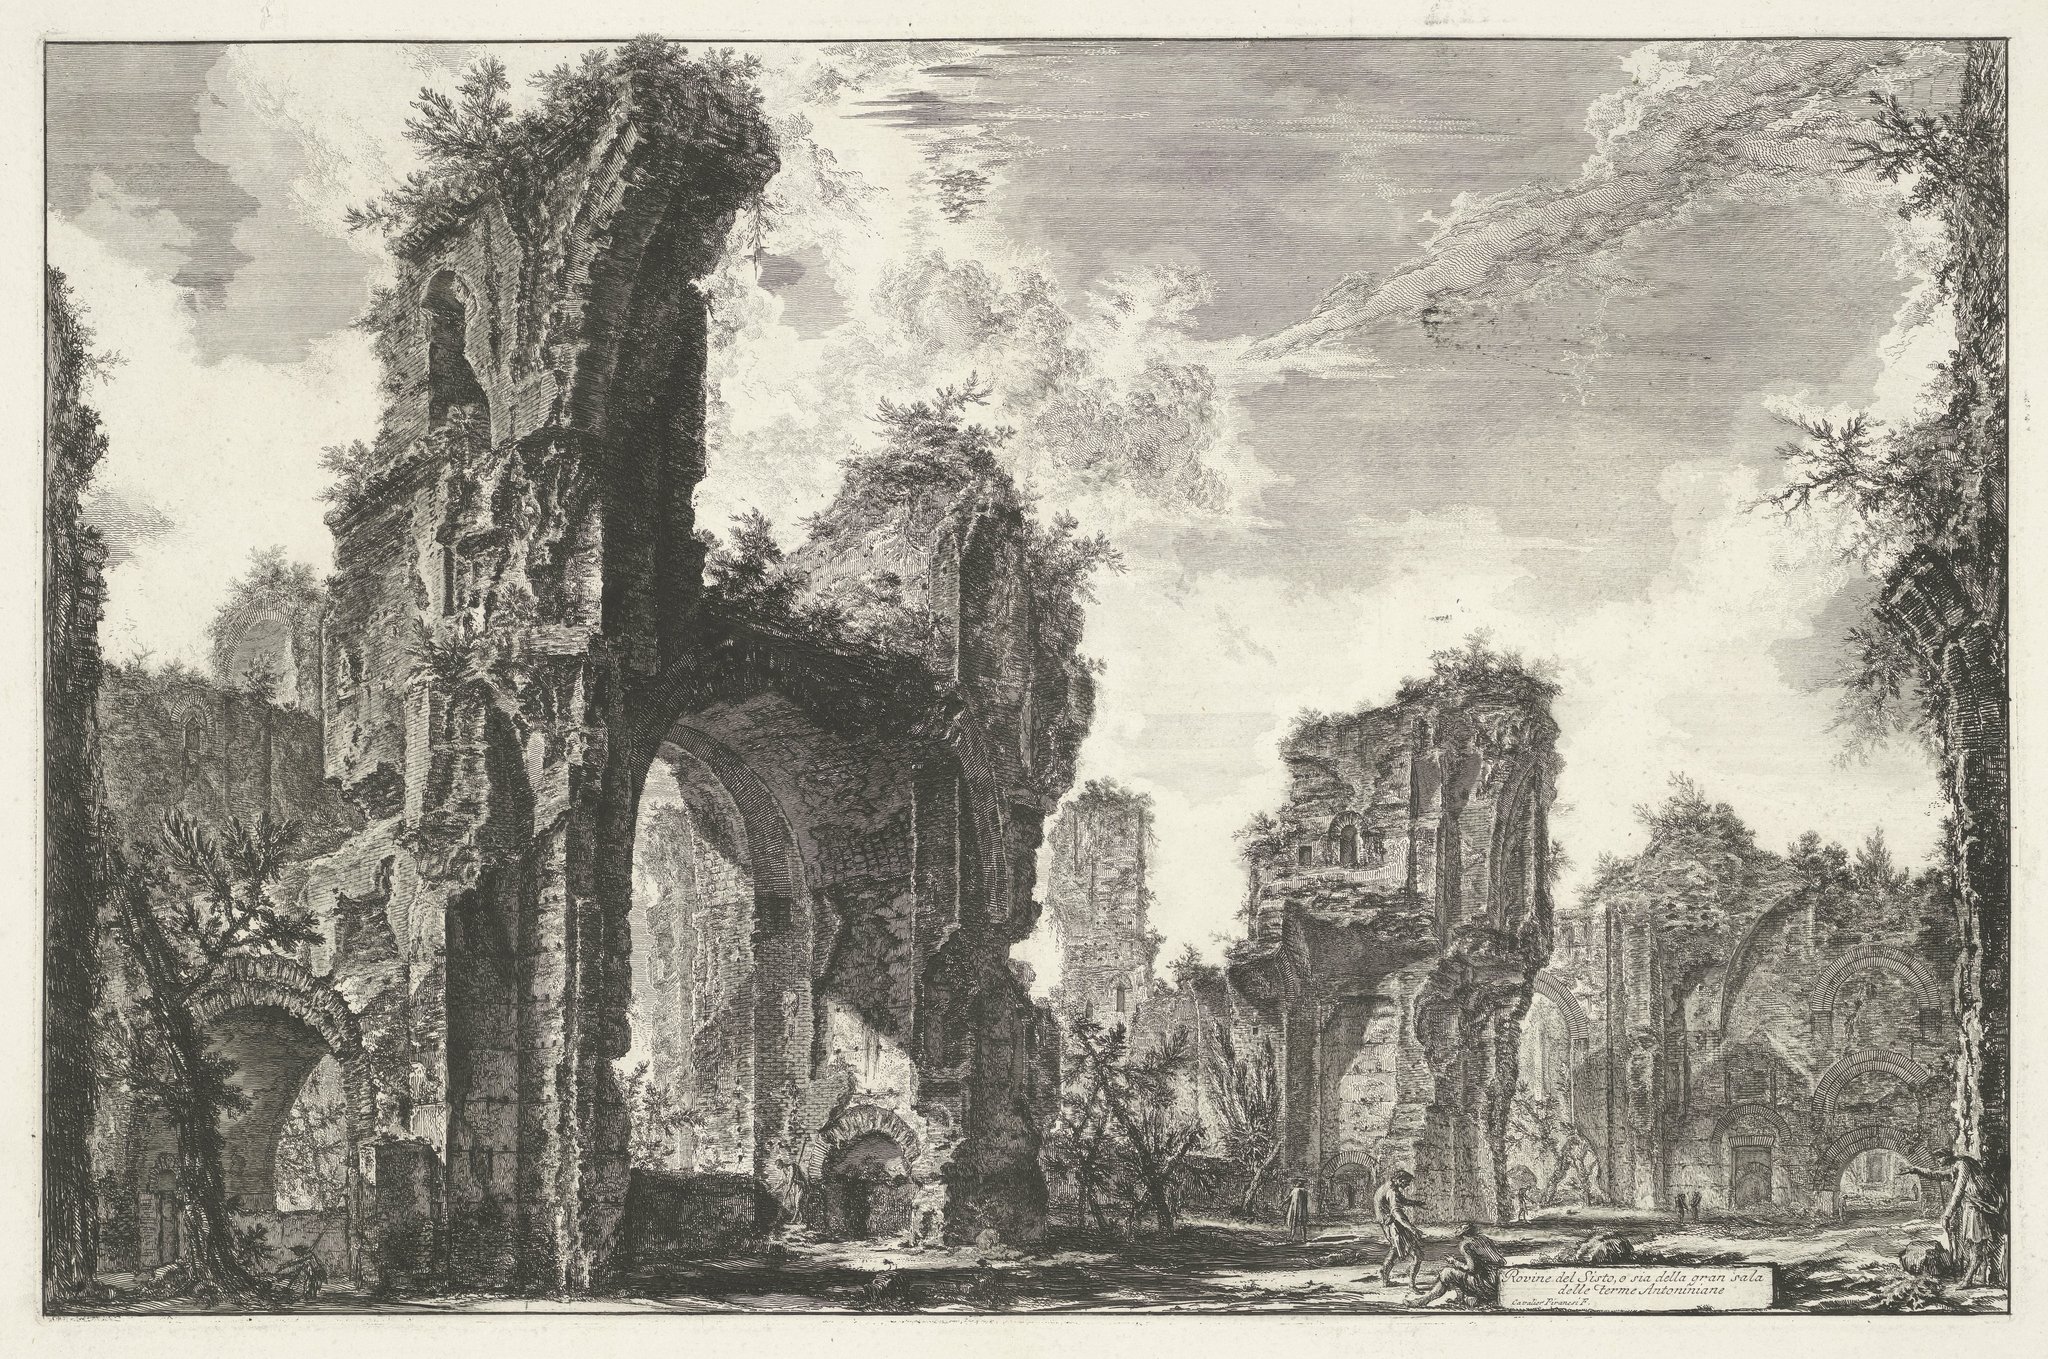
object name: print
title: Thermen van Caracalla te Rome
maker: giovanni battista piranesi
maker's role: designer, draughtsman, print maker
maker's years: 1720-1778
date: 1748-1778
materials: paper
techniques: etching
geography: rome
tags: city-view, and landscape with man-made constructions, ruin of a building ~ architecture, public baths, rome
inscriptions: collector's mark: Lugt 2228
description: Deze prent maakt deel uit van de serie 'Vedute di Roma'. Piranesi werkte aan deze 135 platen tellende serie tussen 1748 en zijn dood in 1778. Francesco Piranesi voegde later nog twee prenten toe aan de reeks van zijn vader.